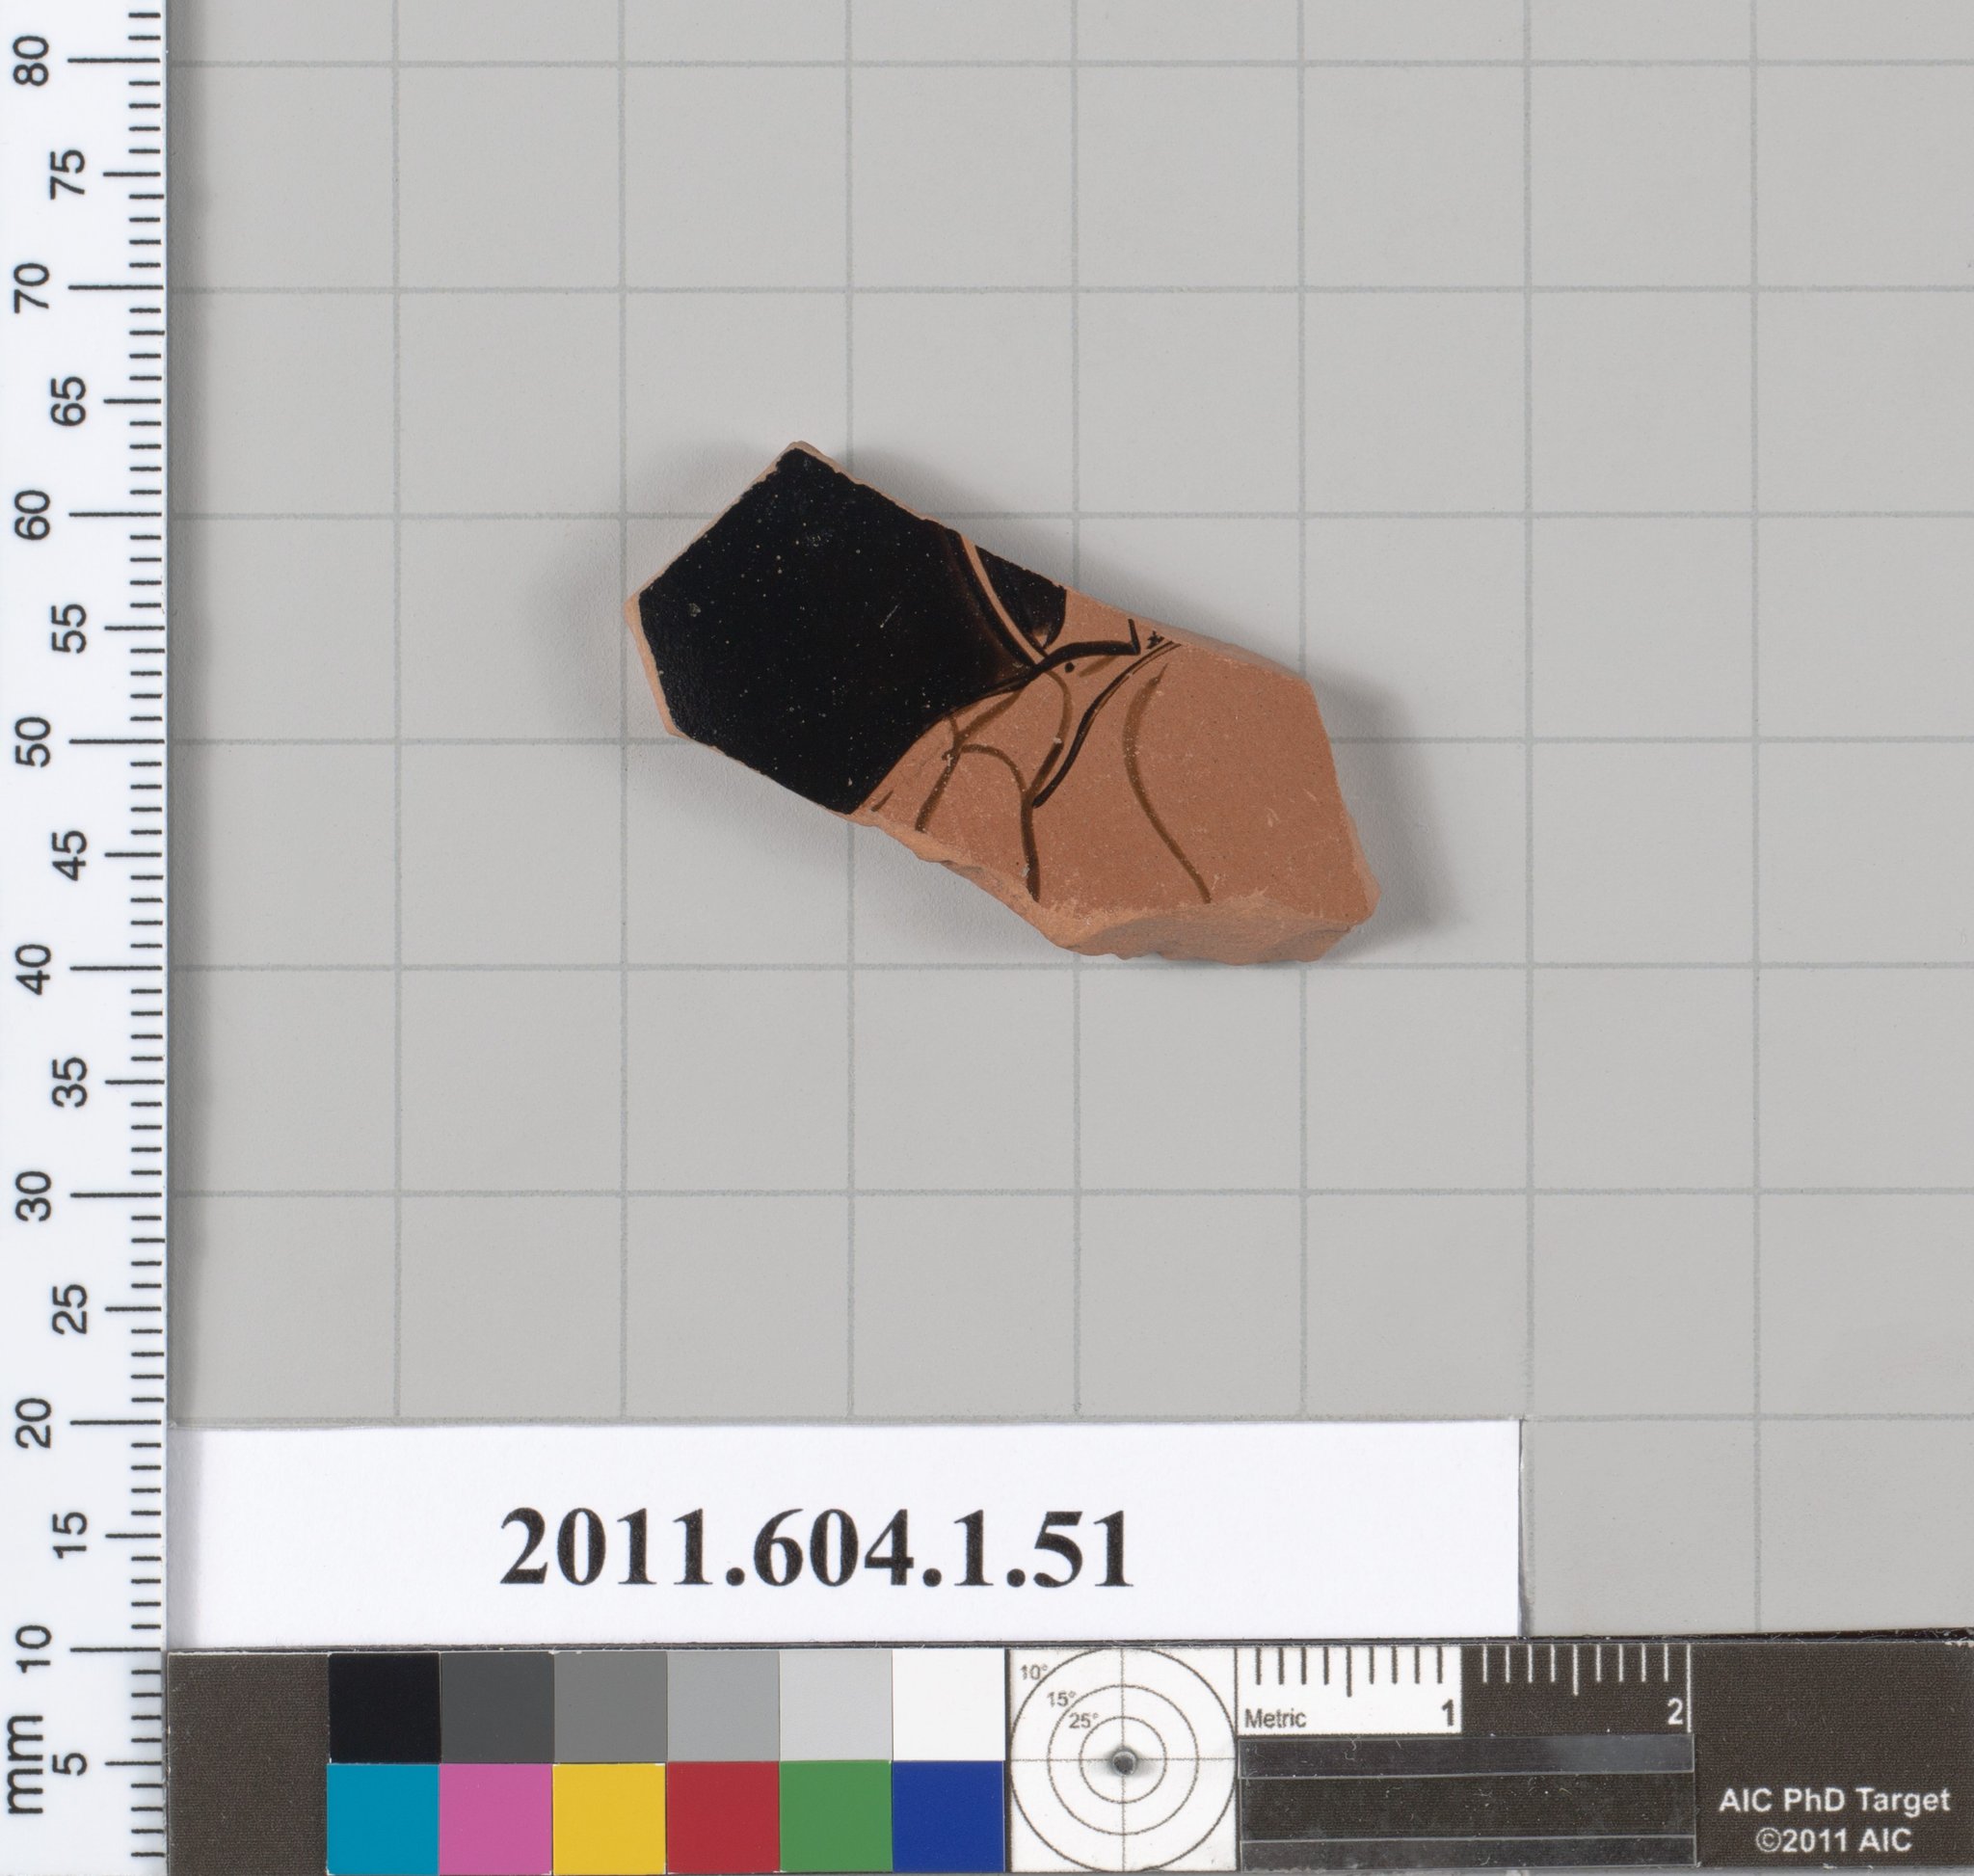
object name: kylix fragment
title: Terracotta fragment of a kylix (drinking cup)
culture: greek, attic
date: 490-480 BCE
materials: terracotta